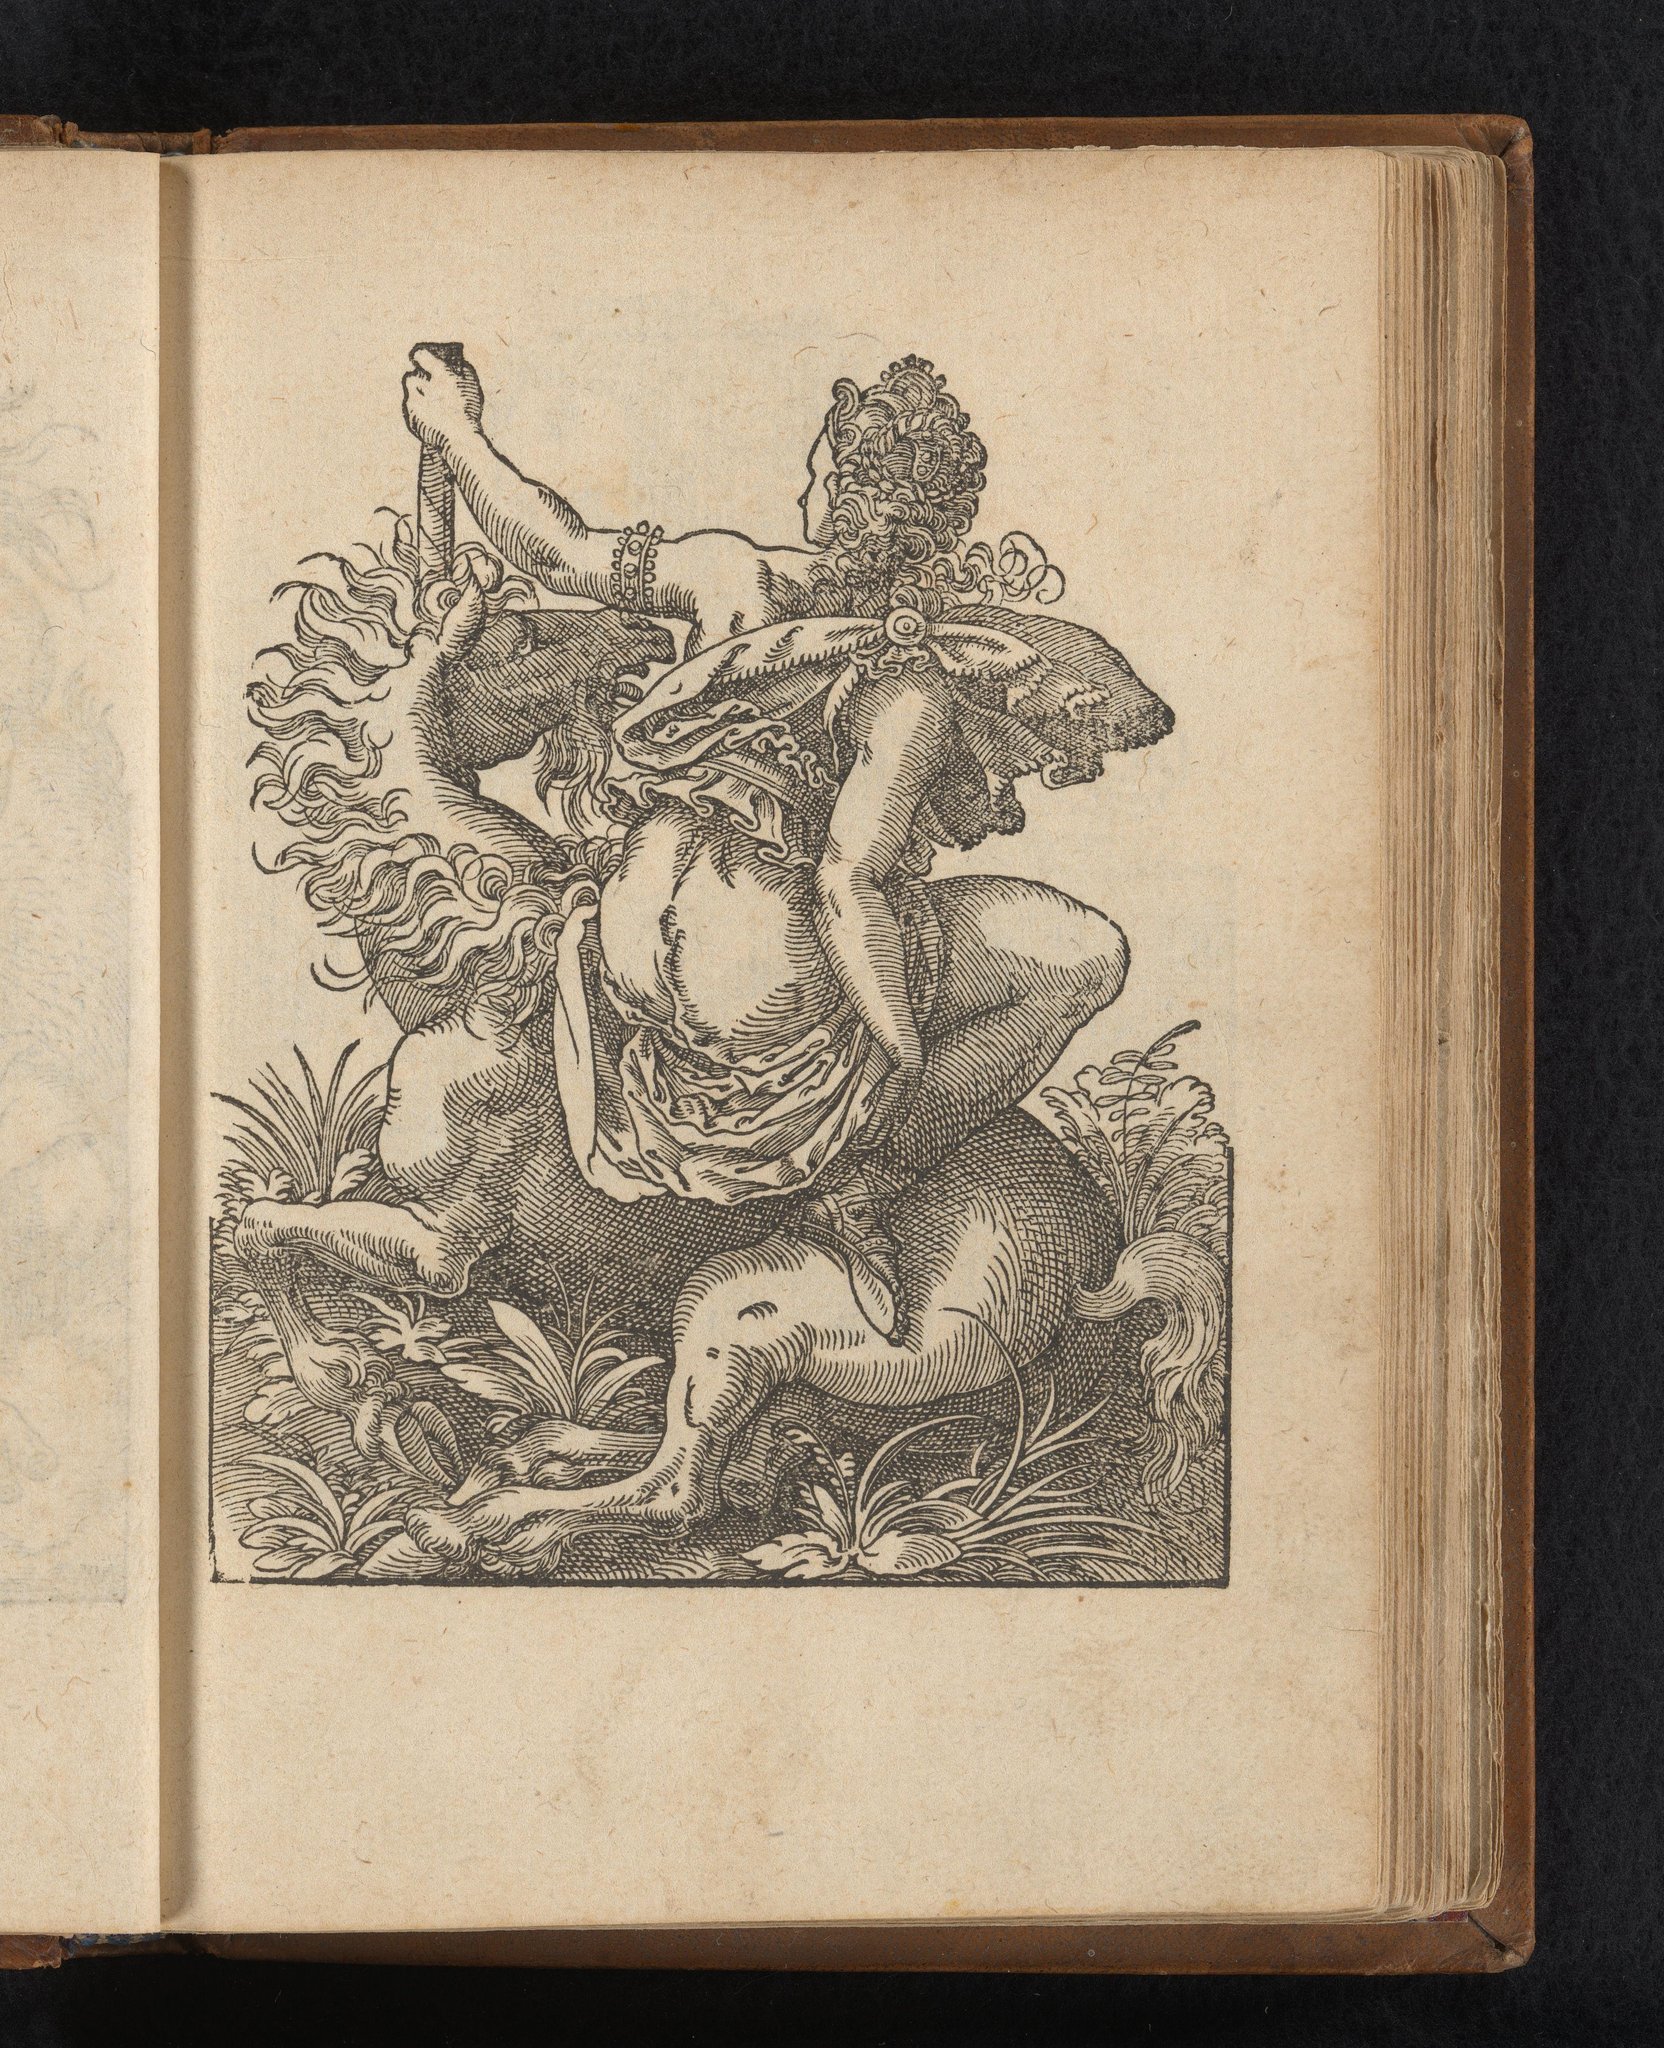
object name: print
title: Nimf op een eenhoorn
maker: Anonymous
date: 1578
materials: paper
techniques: woodcut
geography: nuremberg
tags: unicorn, nymphs (in general); 'ninfe in commune' (ripa)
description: Nimf op een eenhoorn, op de rug gezien. Onderdeel van het modelboek Enchiridion artis pingendi, fingendi & sculpendi met 108 figuren bedoeld voor beginnende schilders, beeldhouwers en prentmakers.